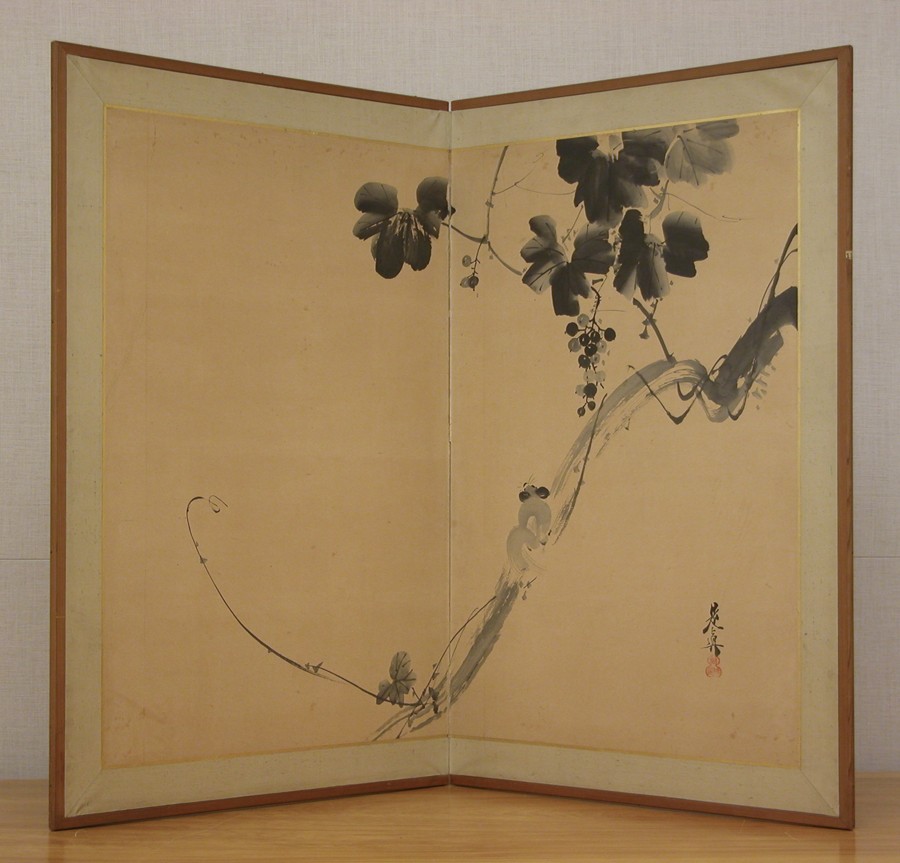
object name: screen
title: Squirrel on Grapevine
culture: japanese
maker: shibata zeshin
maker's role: artist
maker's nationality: japanese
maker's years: 1807-1891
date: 1801-1900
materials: ink, panel, paper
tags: grapes,squirrels,leaves